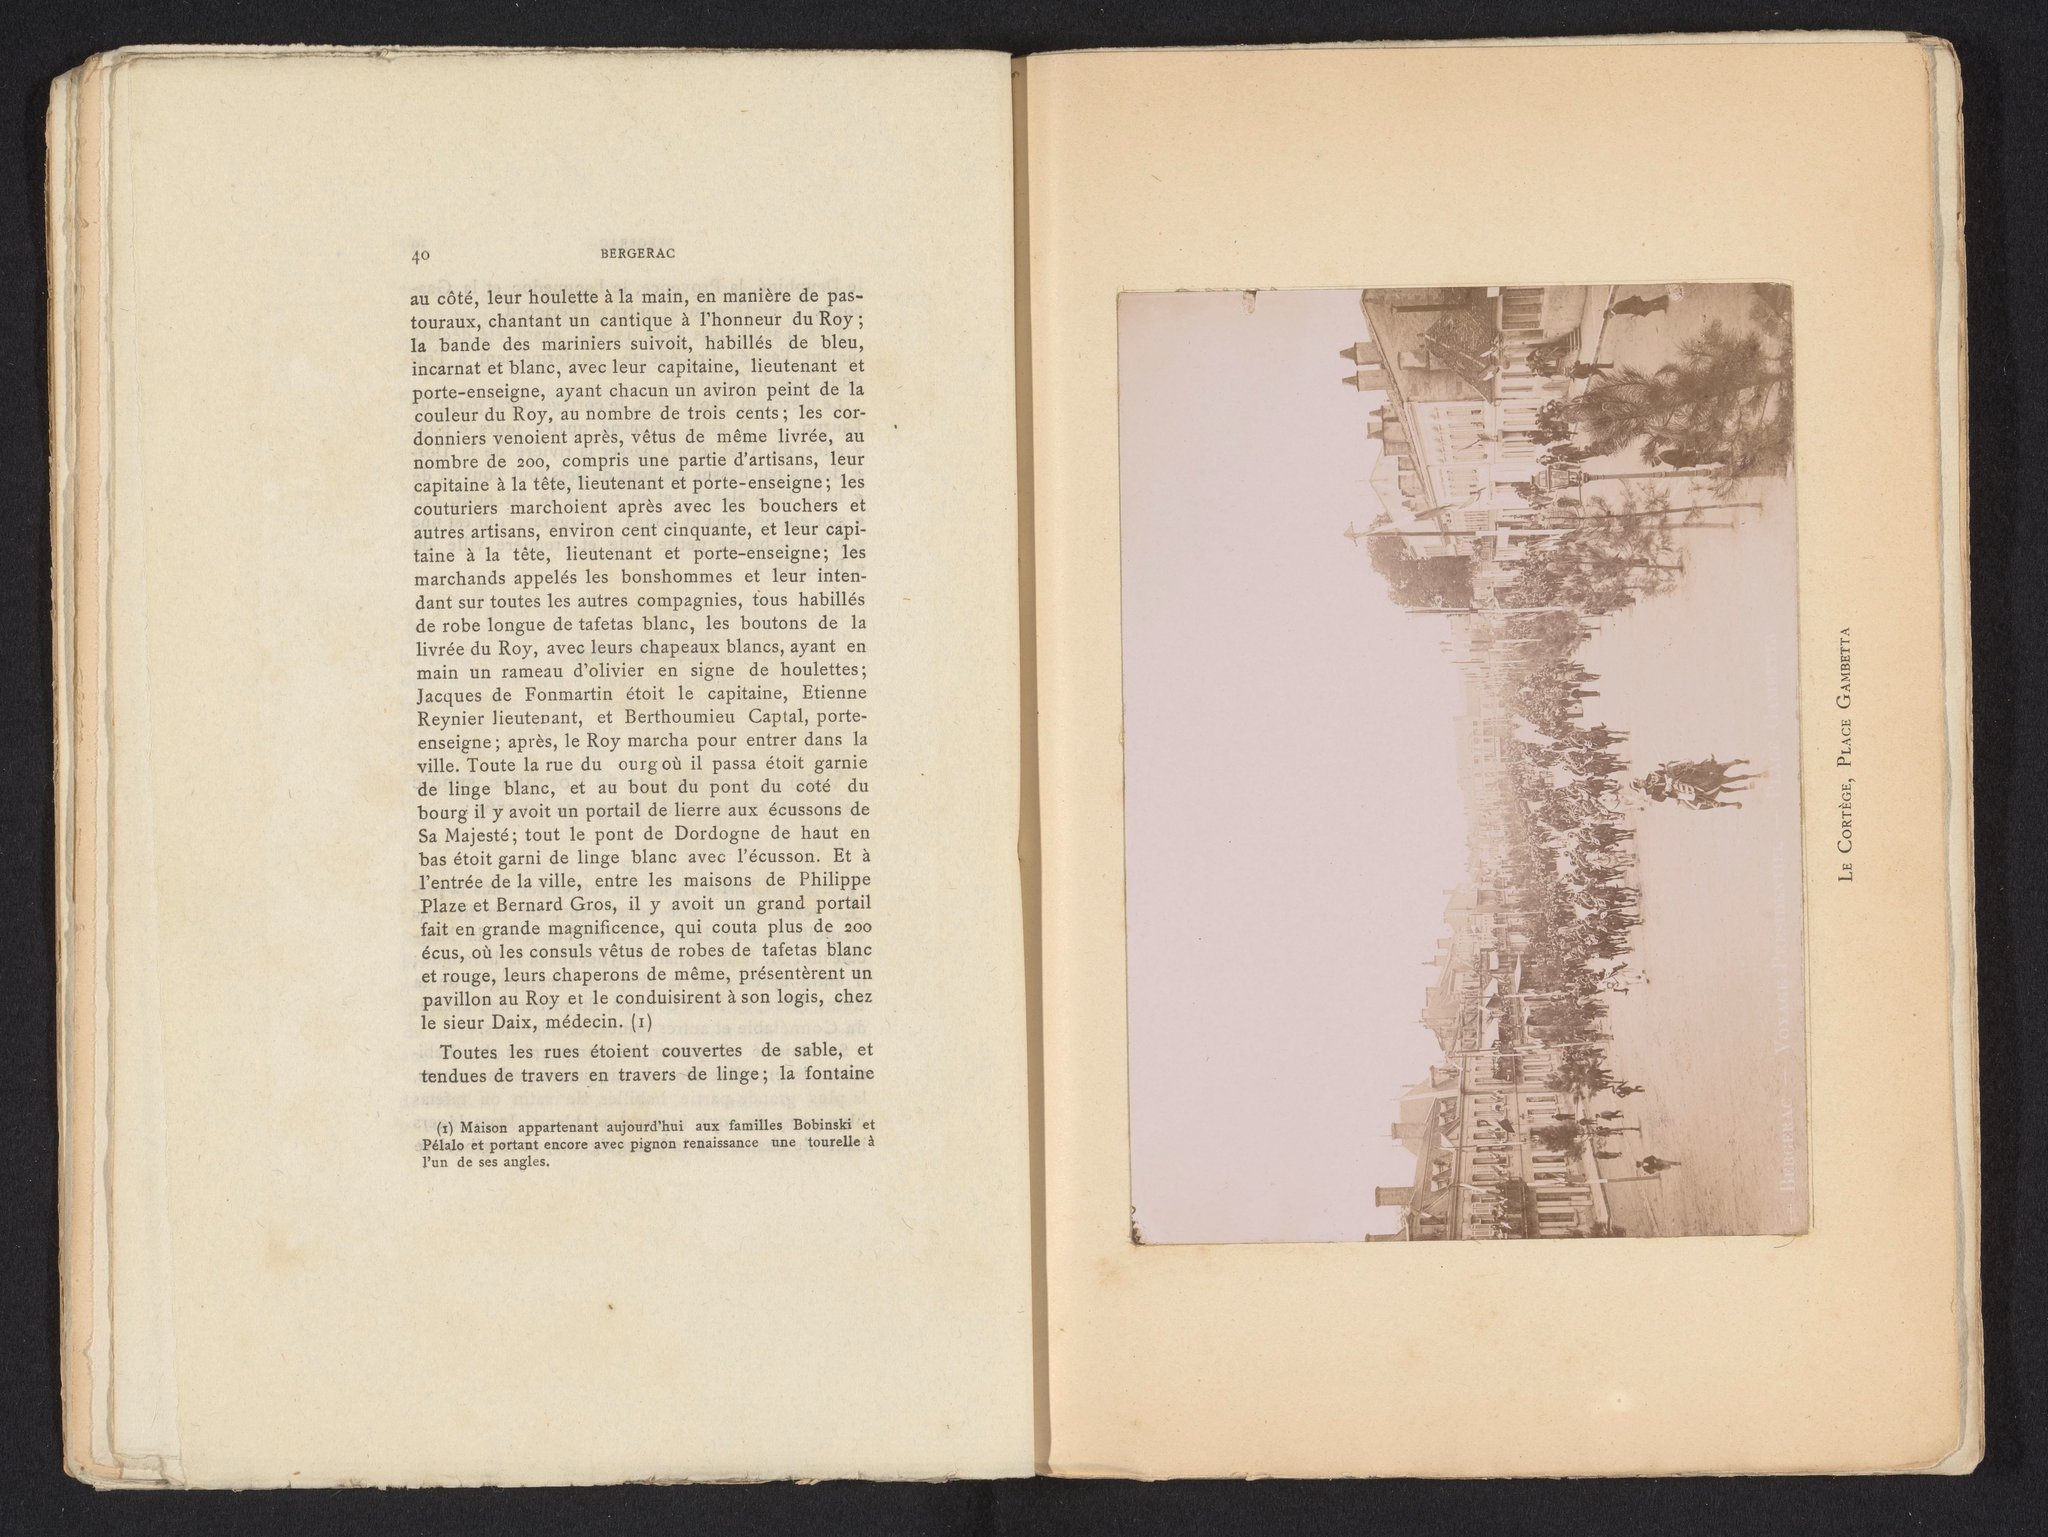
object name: photograph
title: Bergerac- Voyage presidentiel- Place Gambetta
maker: Anonymous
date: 1895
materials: photographic support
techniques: gelatin silver print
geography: bergerac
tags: riding a horse, ass, or mule; rider, horseman, square, place, circus, etc., triumphal entry and public reception, pageant, 'entrée solennelle', 'joyeuse entrée', façade (of house or building)